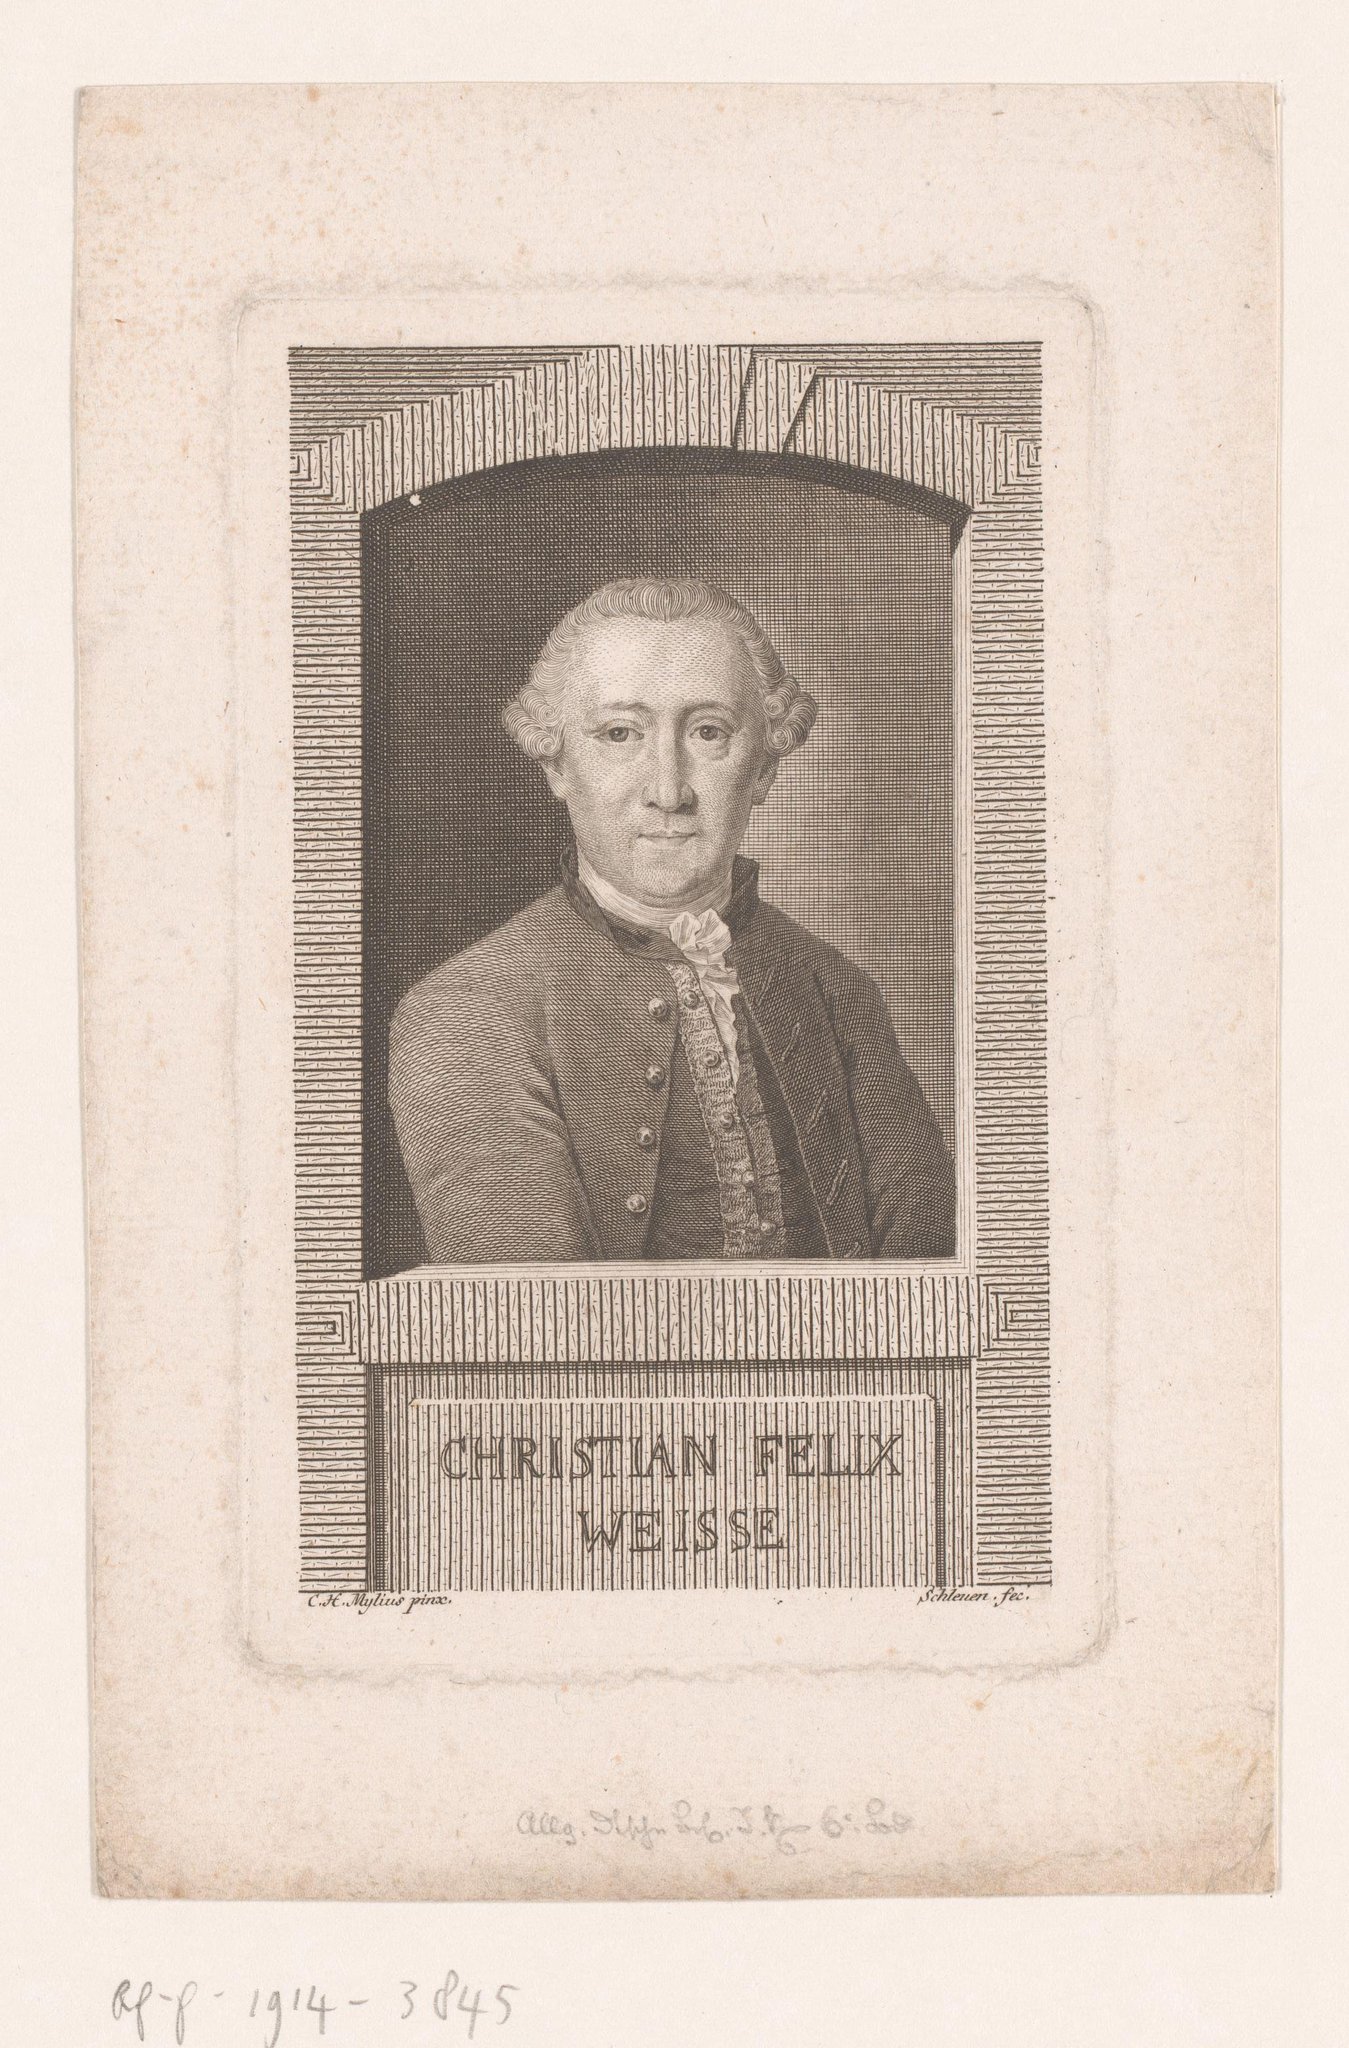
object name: print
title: Portret van Christian Felix Weisse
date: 1721-1771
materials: paper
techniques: engraving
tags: historical persons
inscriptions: collector's mark: Lugt 2228